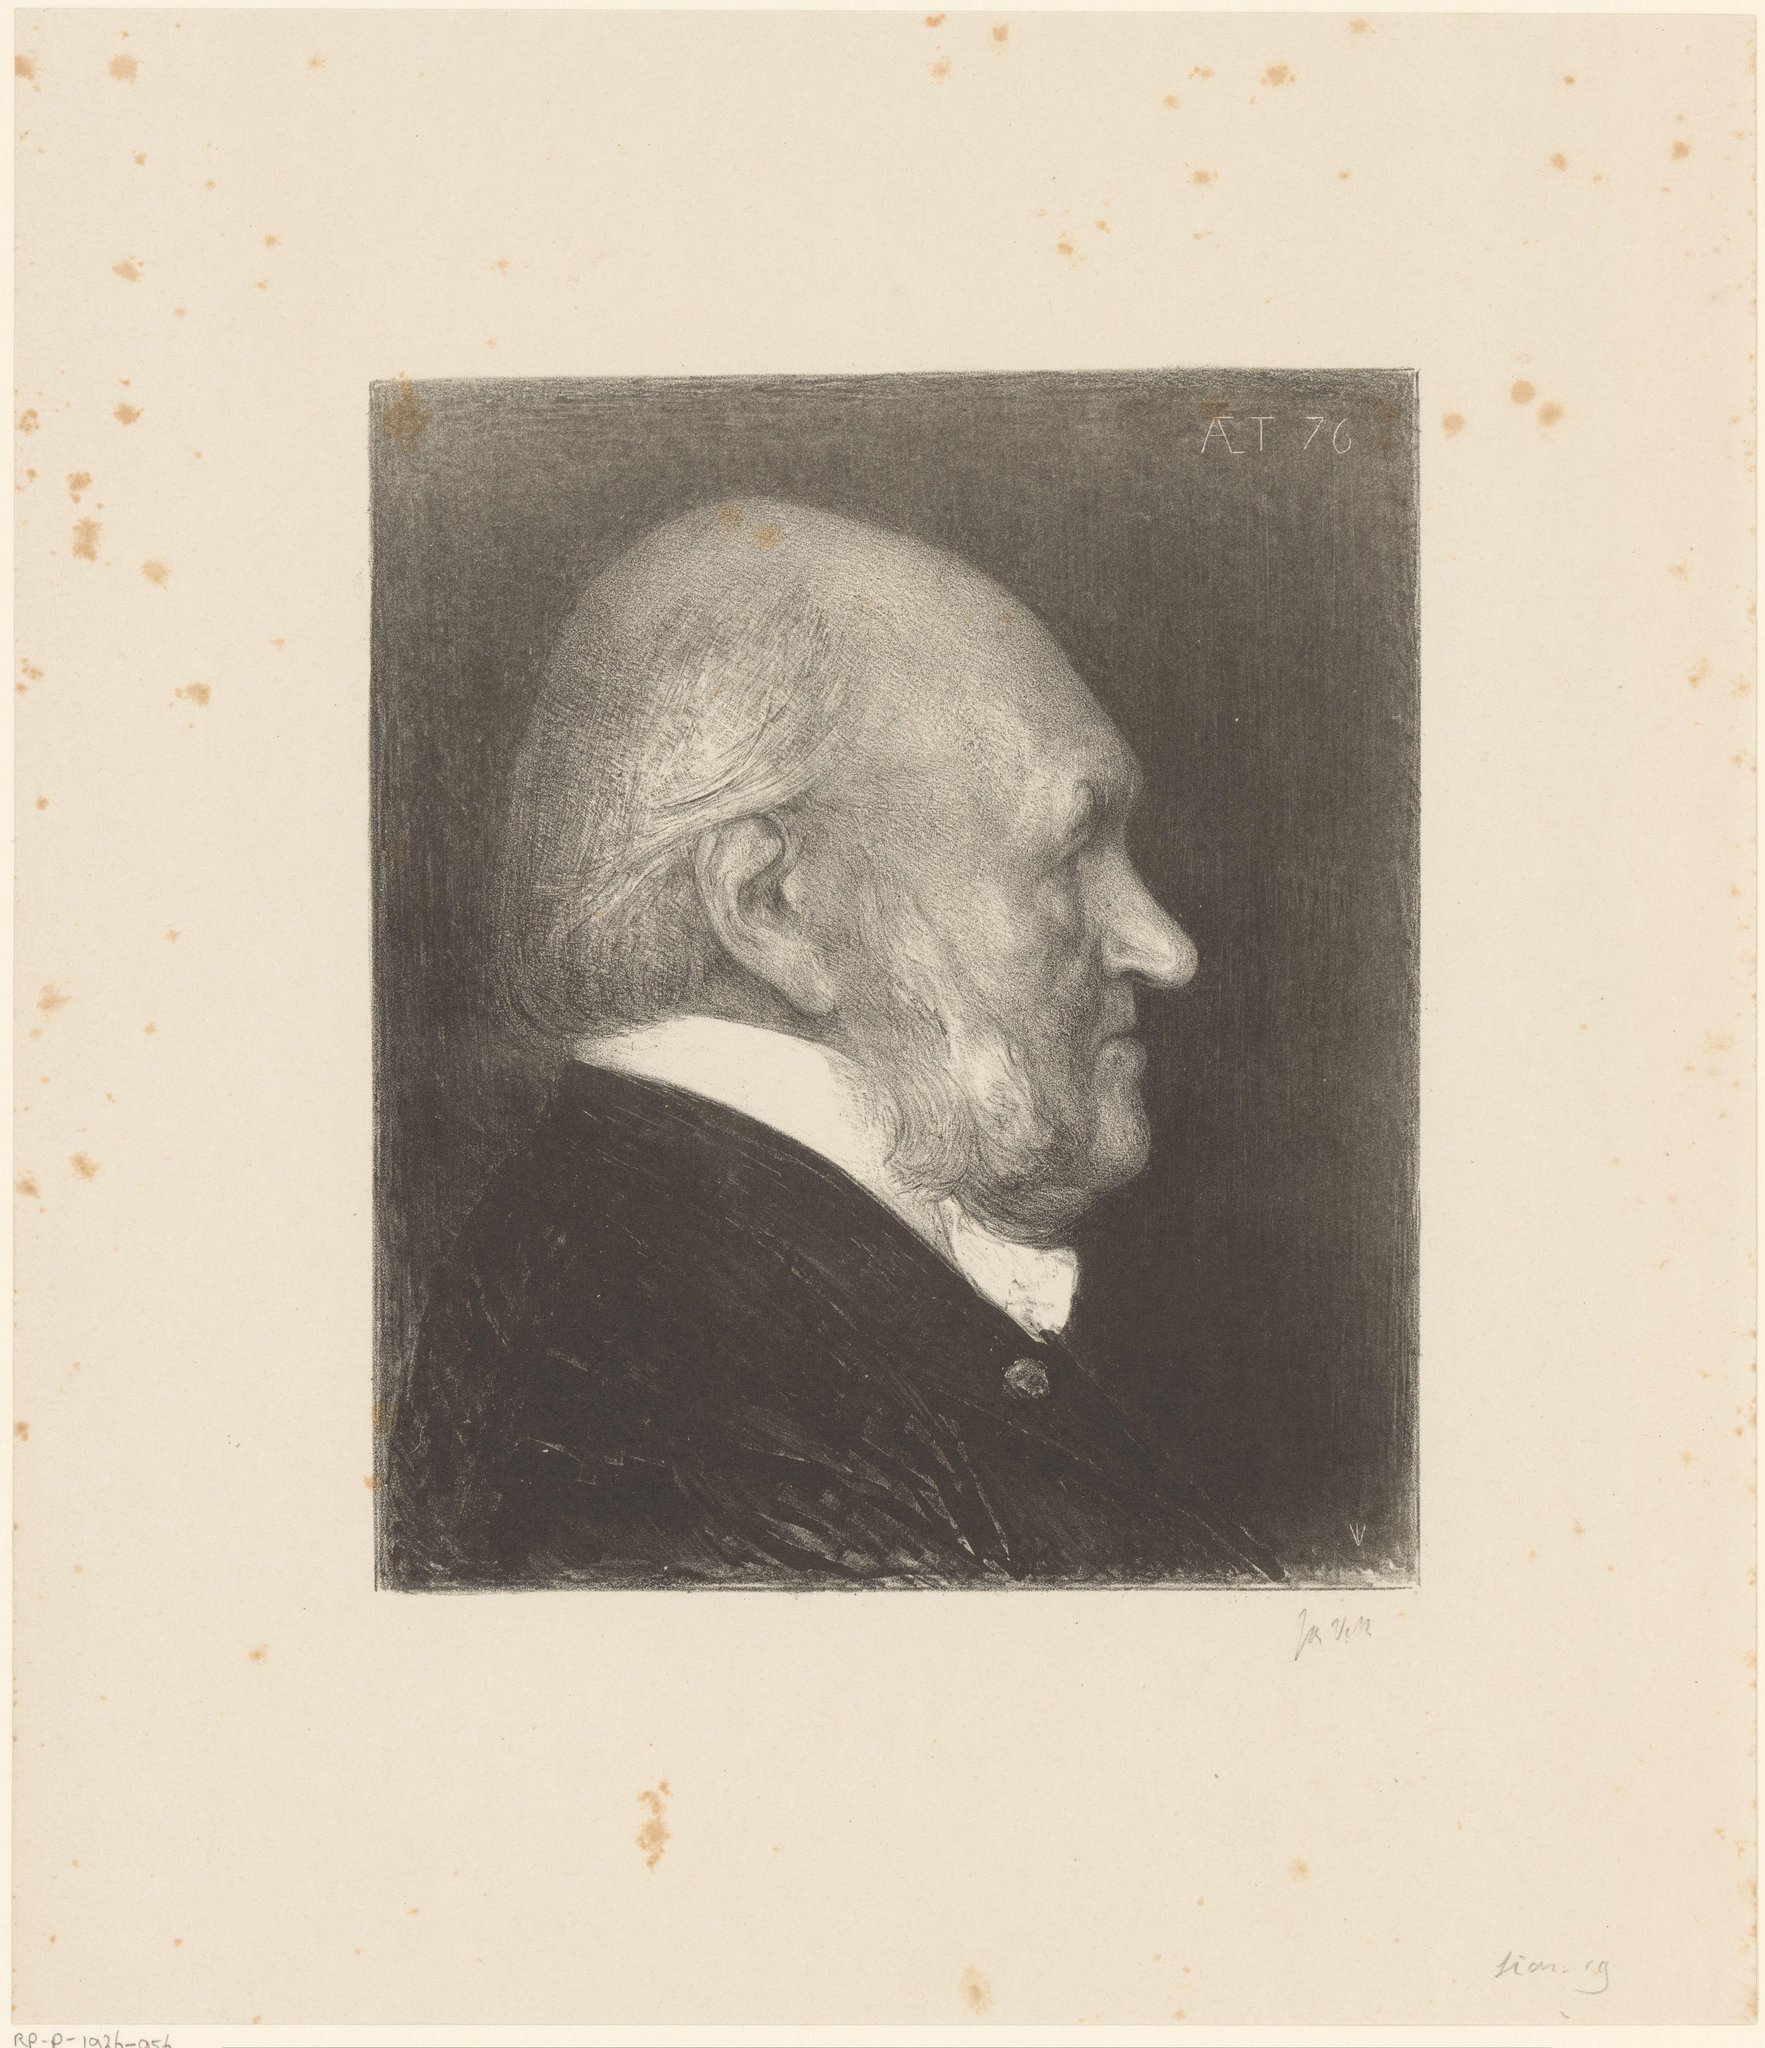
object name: print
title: Bekende tijdgenooten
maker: jan veth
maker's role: designer, draughtsman, painter, print maker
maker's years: 1864-1925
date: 1891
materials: paper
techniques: lithograph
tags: haarlem, utrecht, nicolaas beets, historical persons (+ (full) bust portrait)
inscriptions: signature: ‘Jan Veth’, collector's mark: Lugt 2228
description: Deze prent werd uitgegeven als bijvoegsel bij De Amsterdammer op 8 maart 1891.